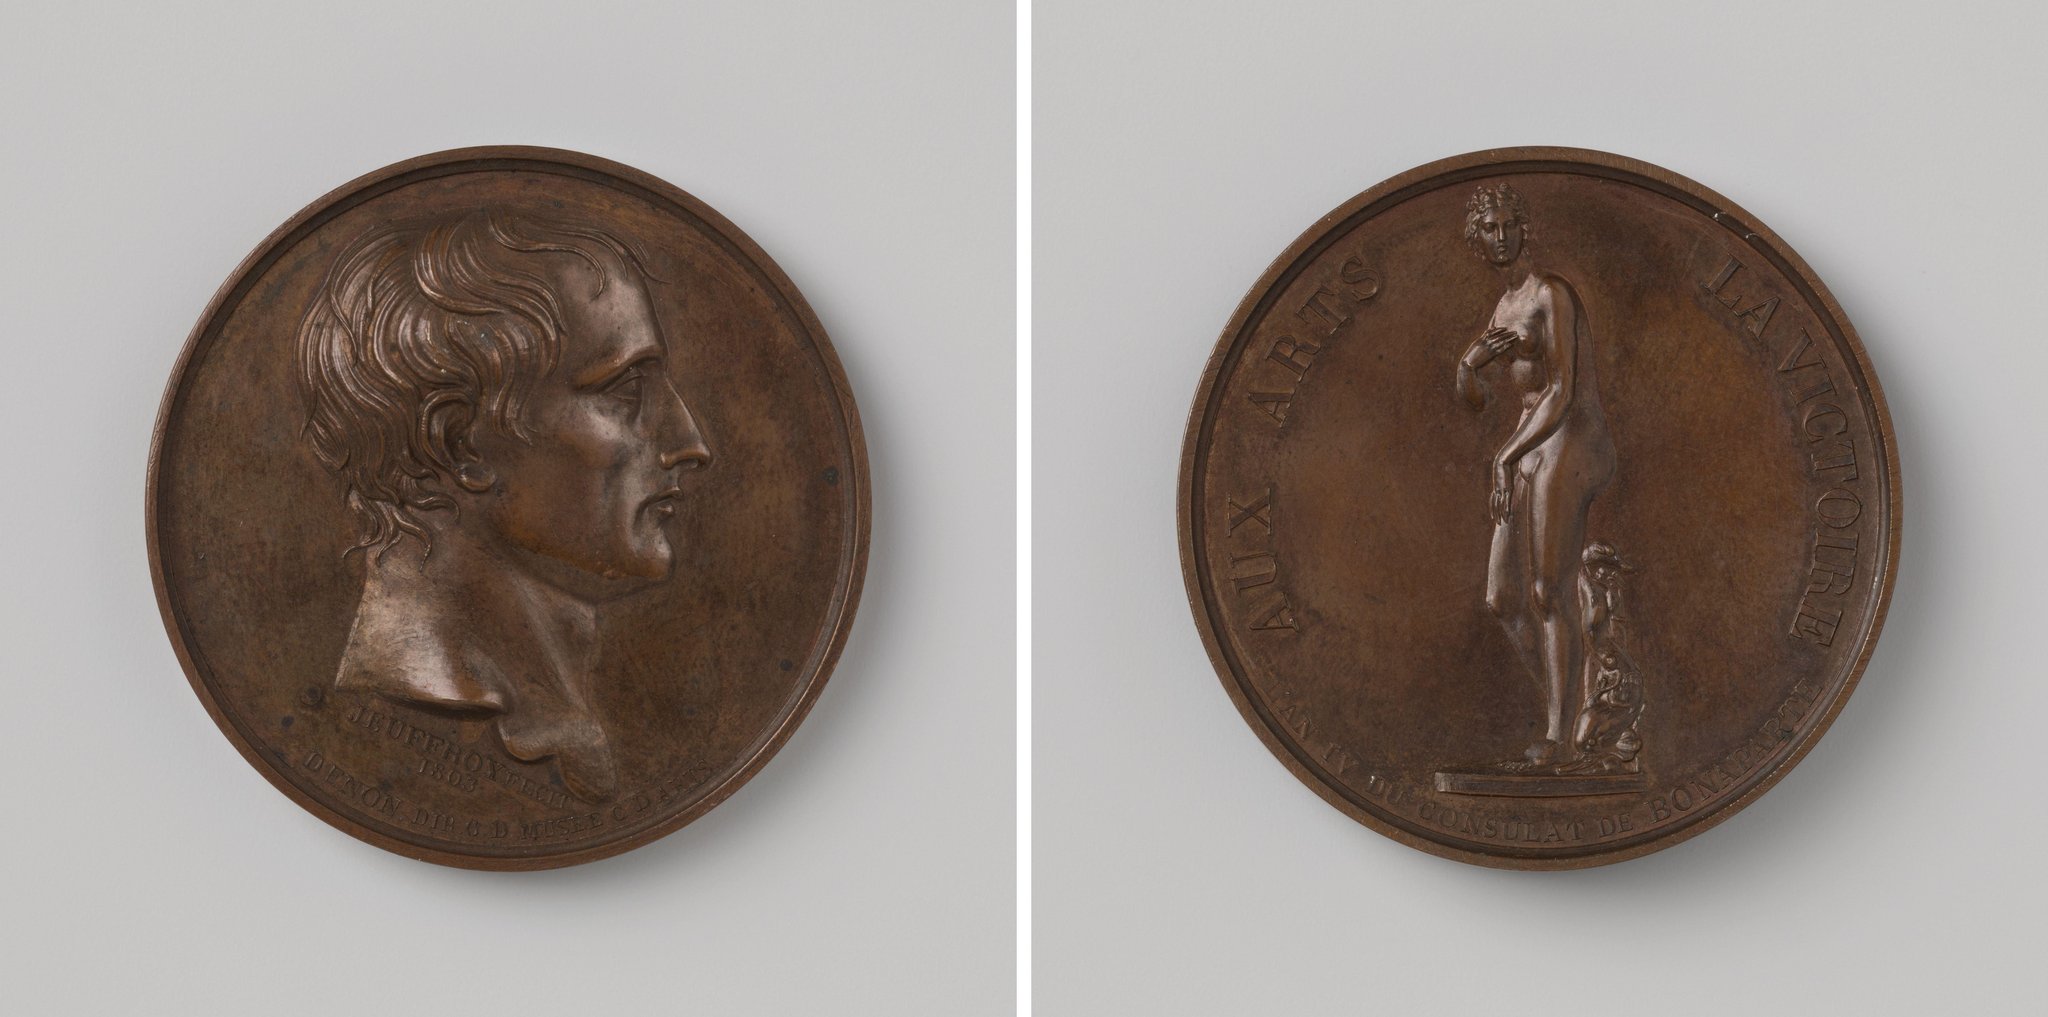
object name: history medal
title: Napoleon Bonaparte, premier consul van Frankrijk en de Venus de' Medici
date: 1805-1815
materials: bronze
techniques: striking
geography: paris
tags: napoleon i (emperor of the french)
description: Bronzen penning. Voorzijde: borststuk man binnen omschrift. Keerzijde: Venus de' Medici binnen omschrift